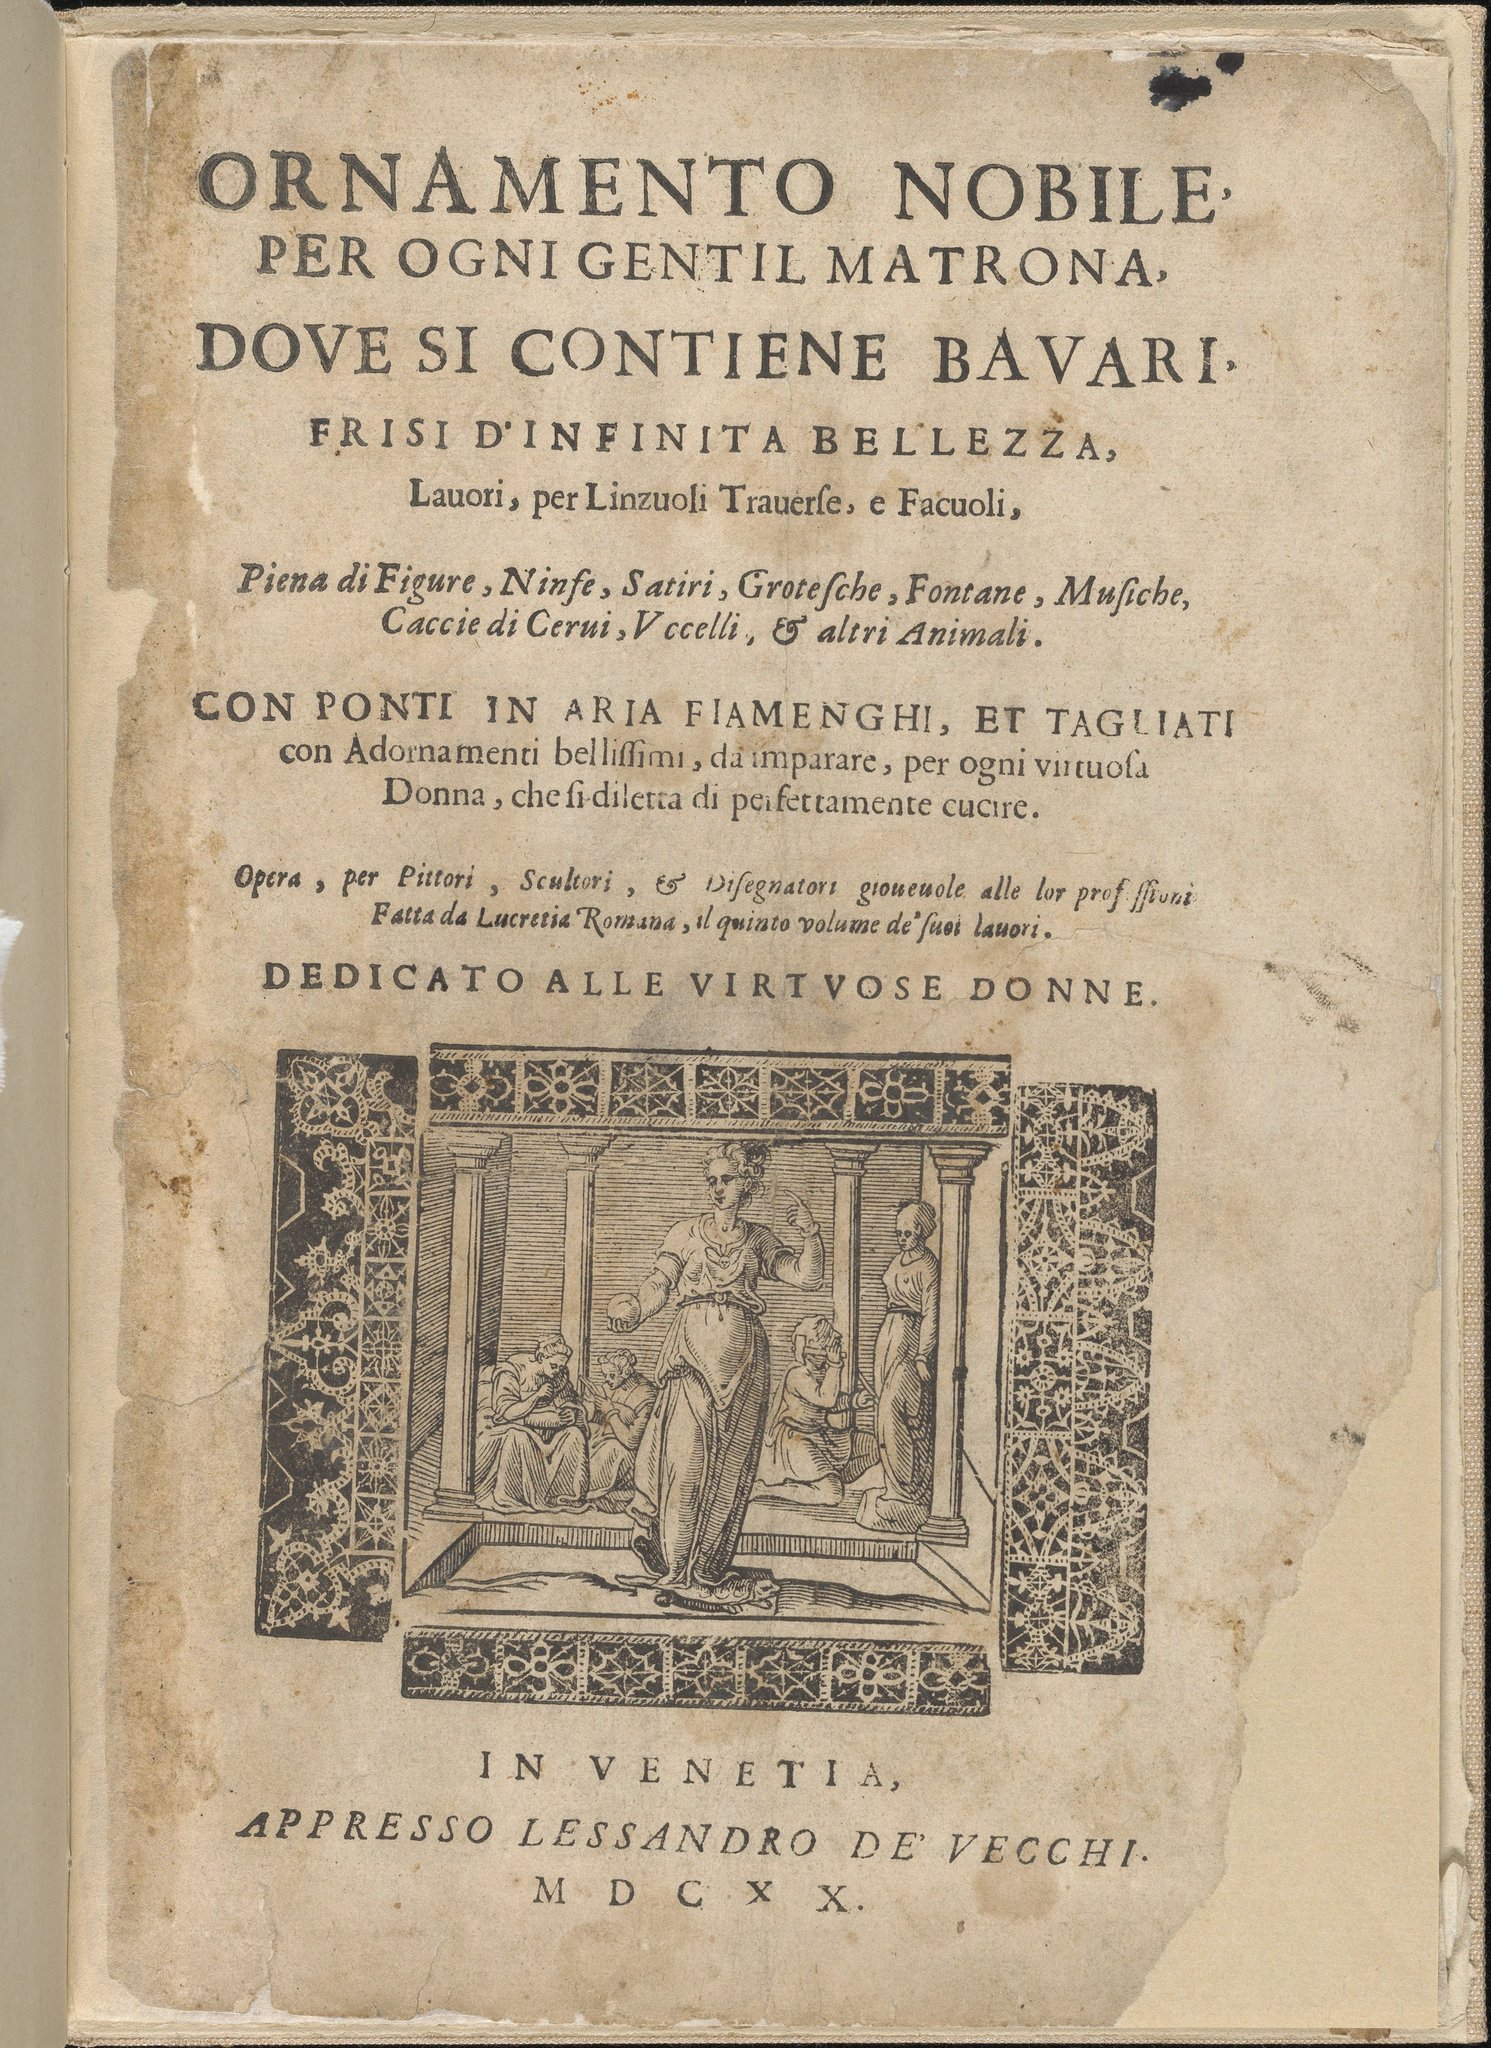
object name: book print ornament architecture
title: Ornamento nobile...Fatta da Lucretia Romana (Libro V of the Corona)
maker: cesare vecellio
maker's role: author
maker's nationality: italian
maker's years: 1521-1601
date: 1620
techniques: woodcut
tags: women